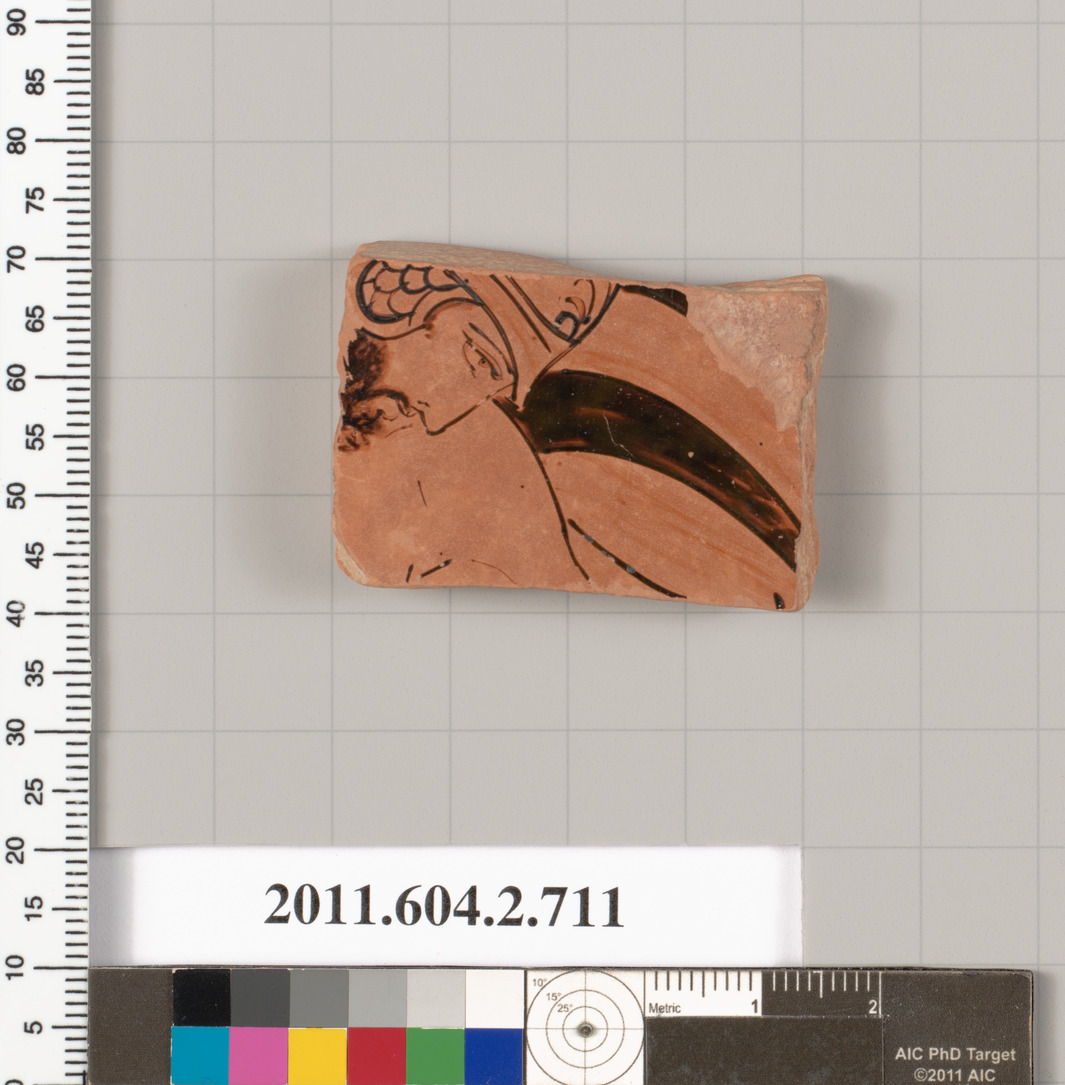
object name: calyx krater fragment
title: Terracotta fragment of a calyx-krater (bowl for mixing wine and water)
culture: greek, attic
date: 460-450 BCE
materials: terracotta